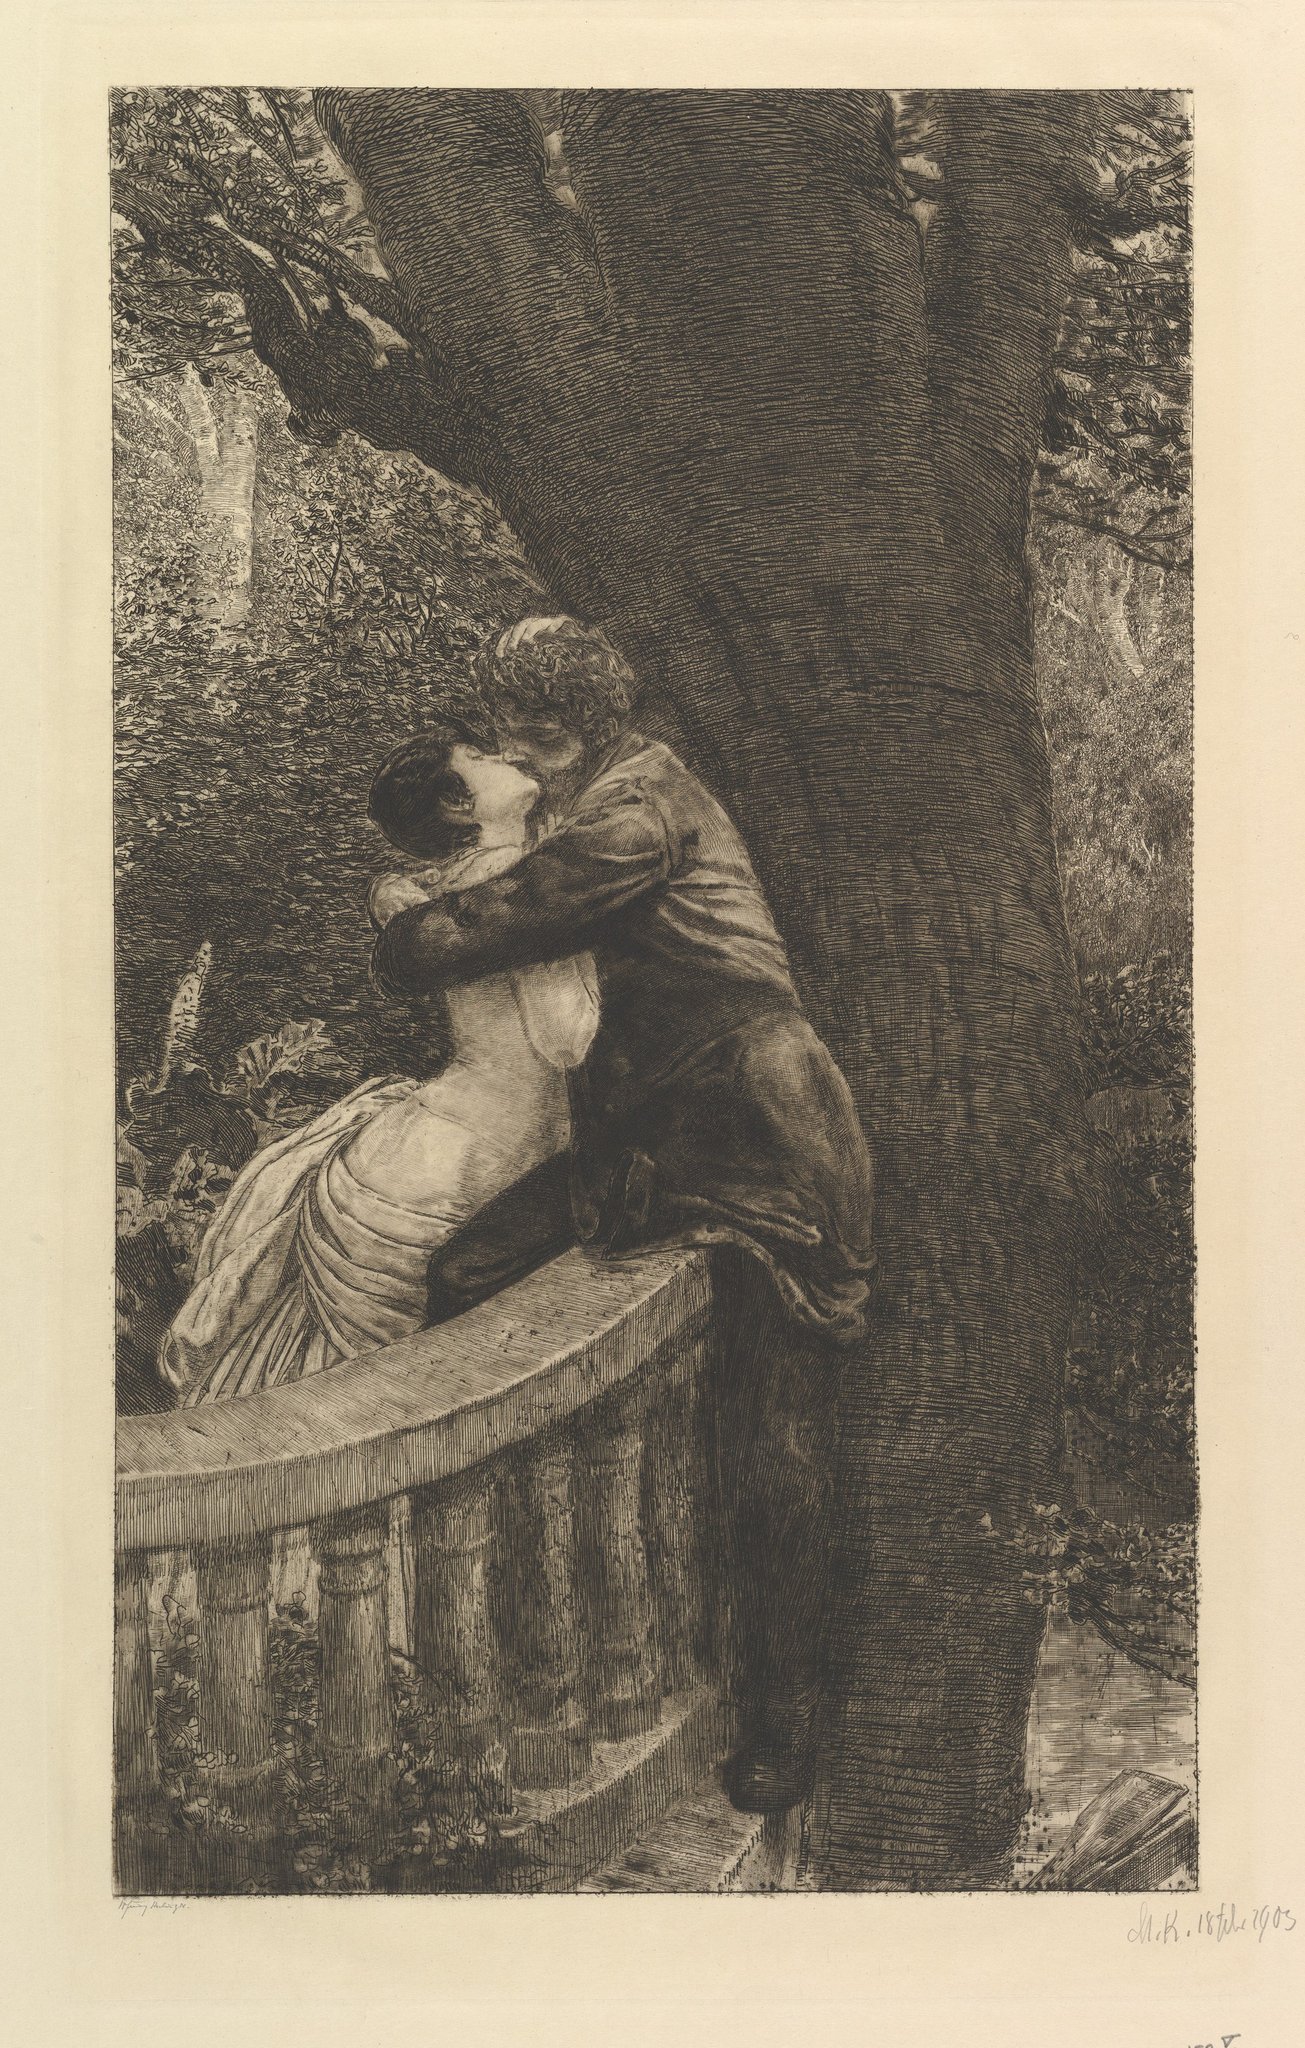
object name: print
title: In the Park (from the series A Love)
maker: max klinger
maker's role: artist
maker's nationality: german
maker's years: 1857-1920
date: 1887-1903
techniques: engraving, etching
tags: couples,men,women